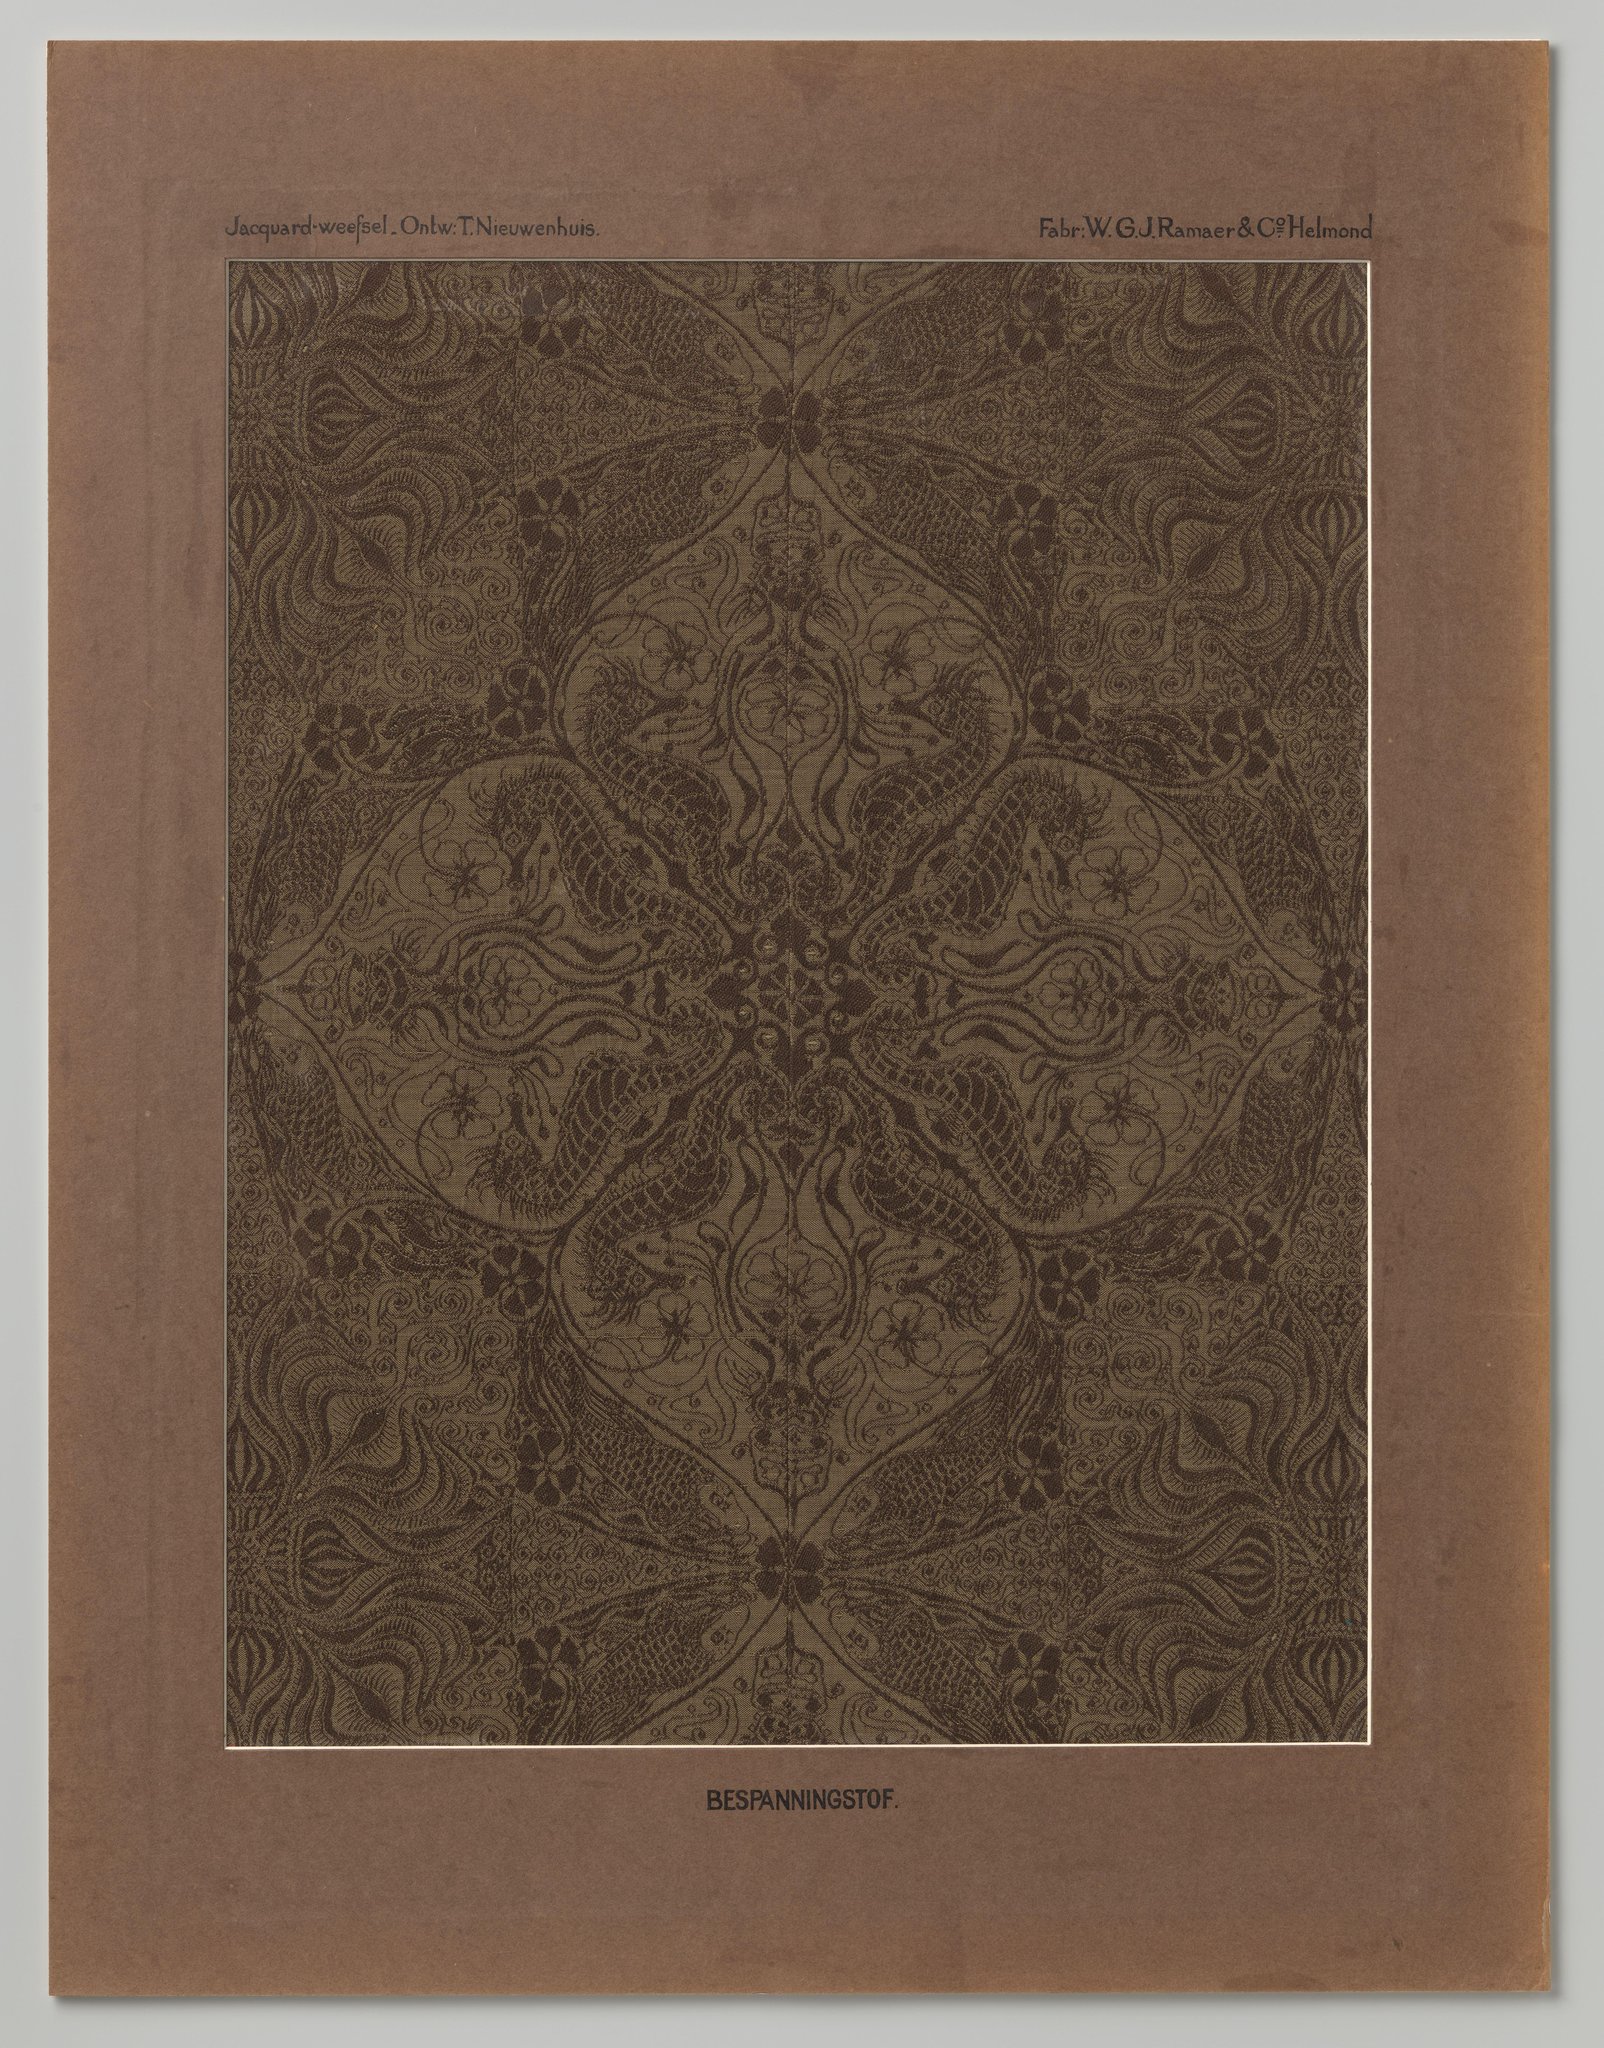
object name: sample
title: Staal bespanningsstof naar ontwerp van Theo Nieuwenhuis in passe-partout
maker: theo nieuwenhuis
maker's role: designer, draughtsman, print maker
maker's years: 1866-1951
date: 1910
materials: cardboard, cotton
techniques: jacquard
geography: netherlands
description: Staal bespanningsstof van jacquardgeweven katoen bestaande uit twee aan elkaar genaaide stukken, naar ontwerp van Theo Nieuwenhuis. Het patroon bestaat uit florale motieven met vissen en andere zeedieren als zeepaarden en inktvissen. In origineel passe-partout.